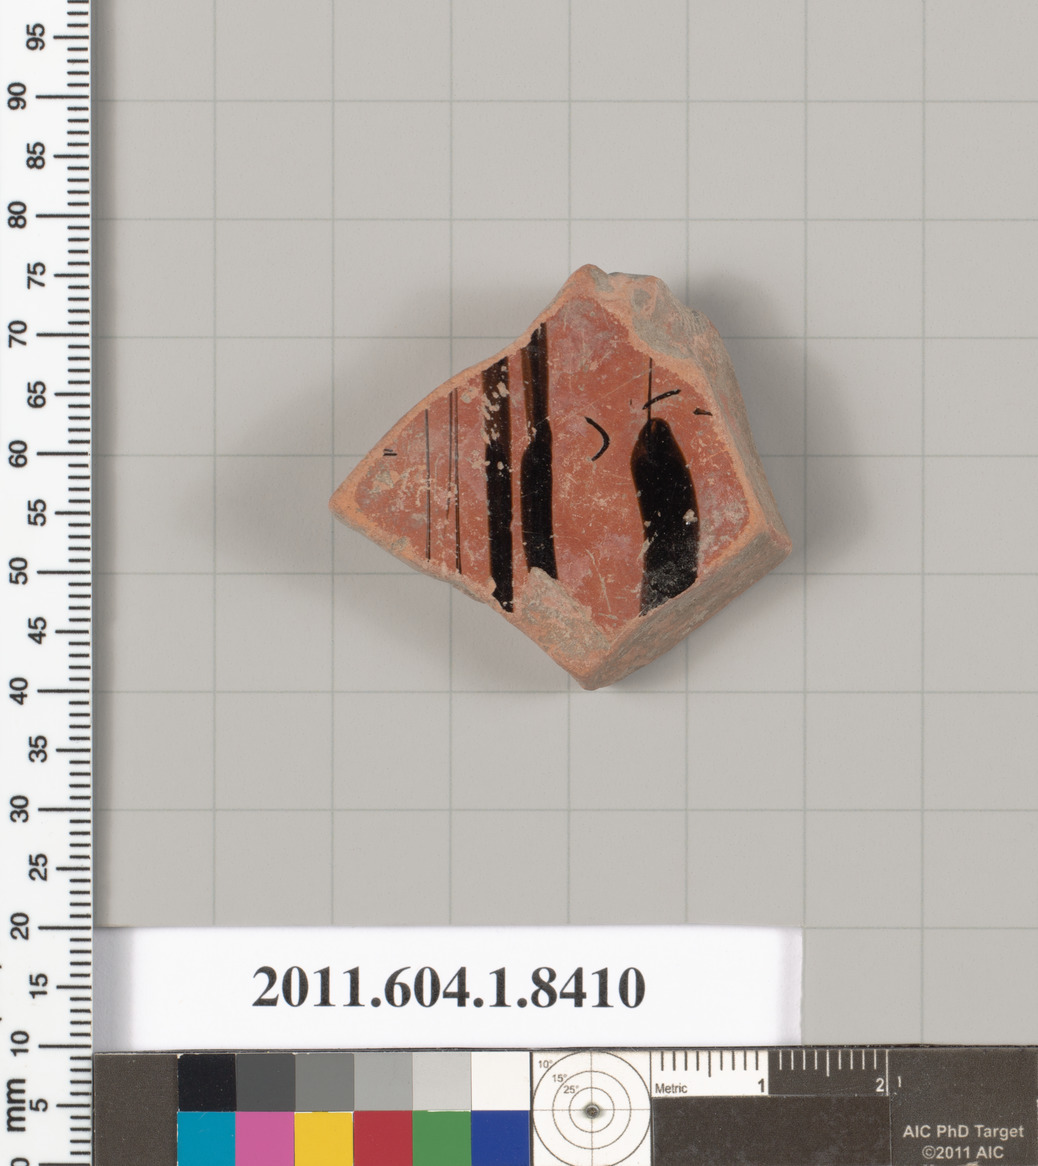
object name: kylix fragment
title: Terracotta fragment of a kylix (drinking cup)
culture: greek, attic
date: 434-368 BCE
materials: terracotta